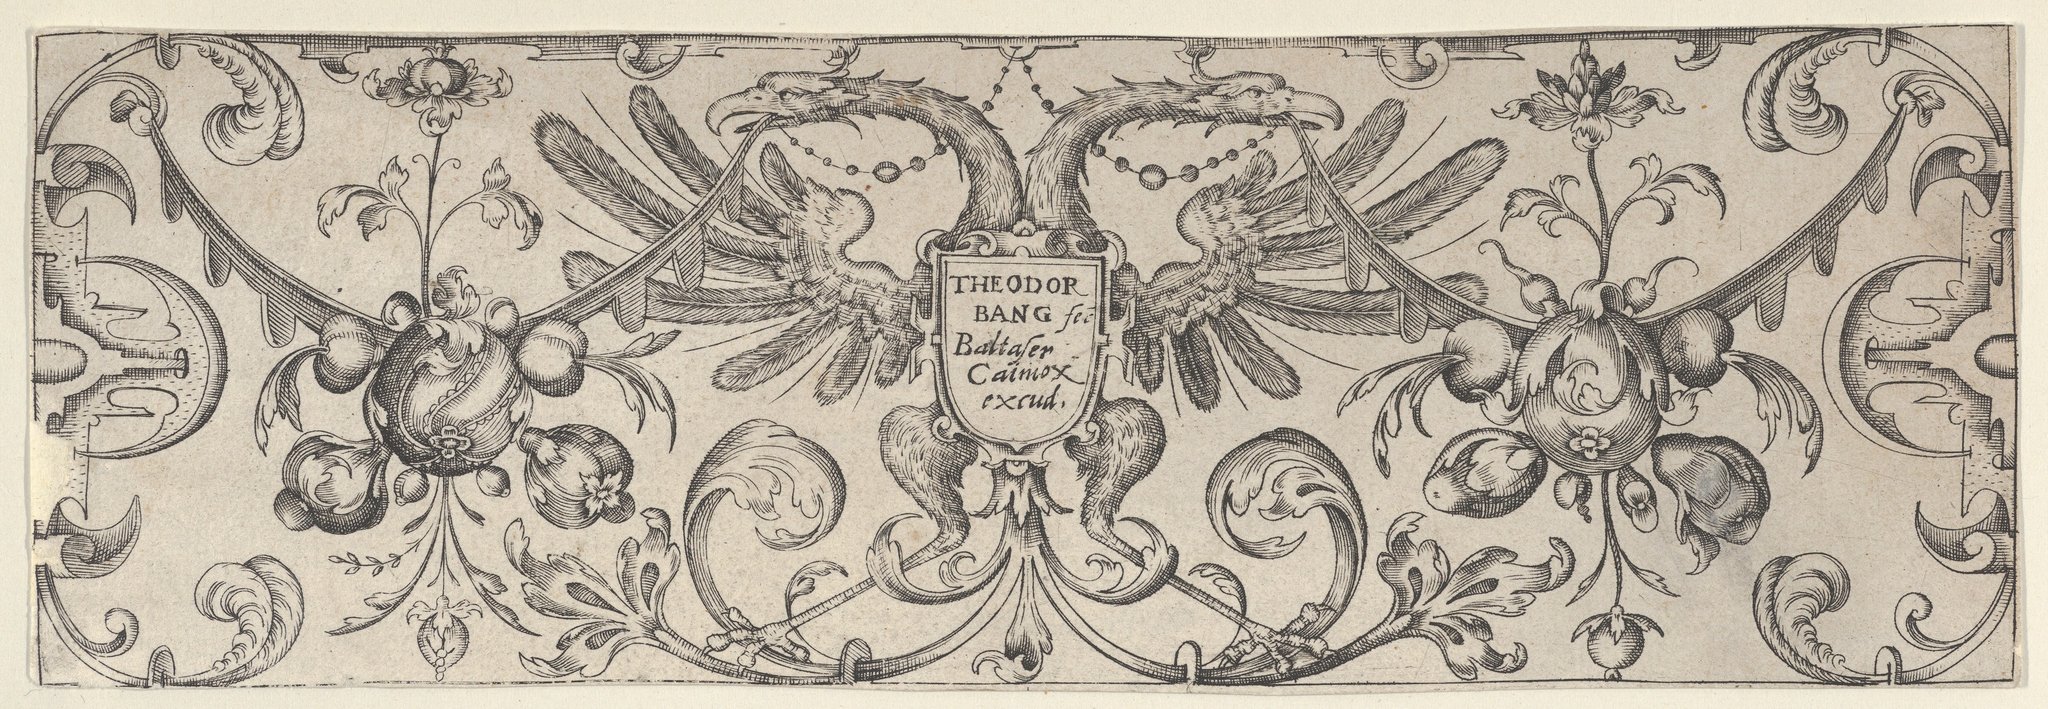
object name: ornament architecture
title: Plate 1, from "Friezes with Birds, Flowers and Meandering Wreaths and Scrolls"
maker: theodor bang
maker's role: artist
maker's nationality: german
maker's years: 1606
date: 1600-1617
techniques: etching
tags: eagles,flowers